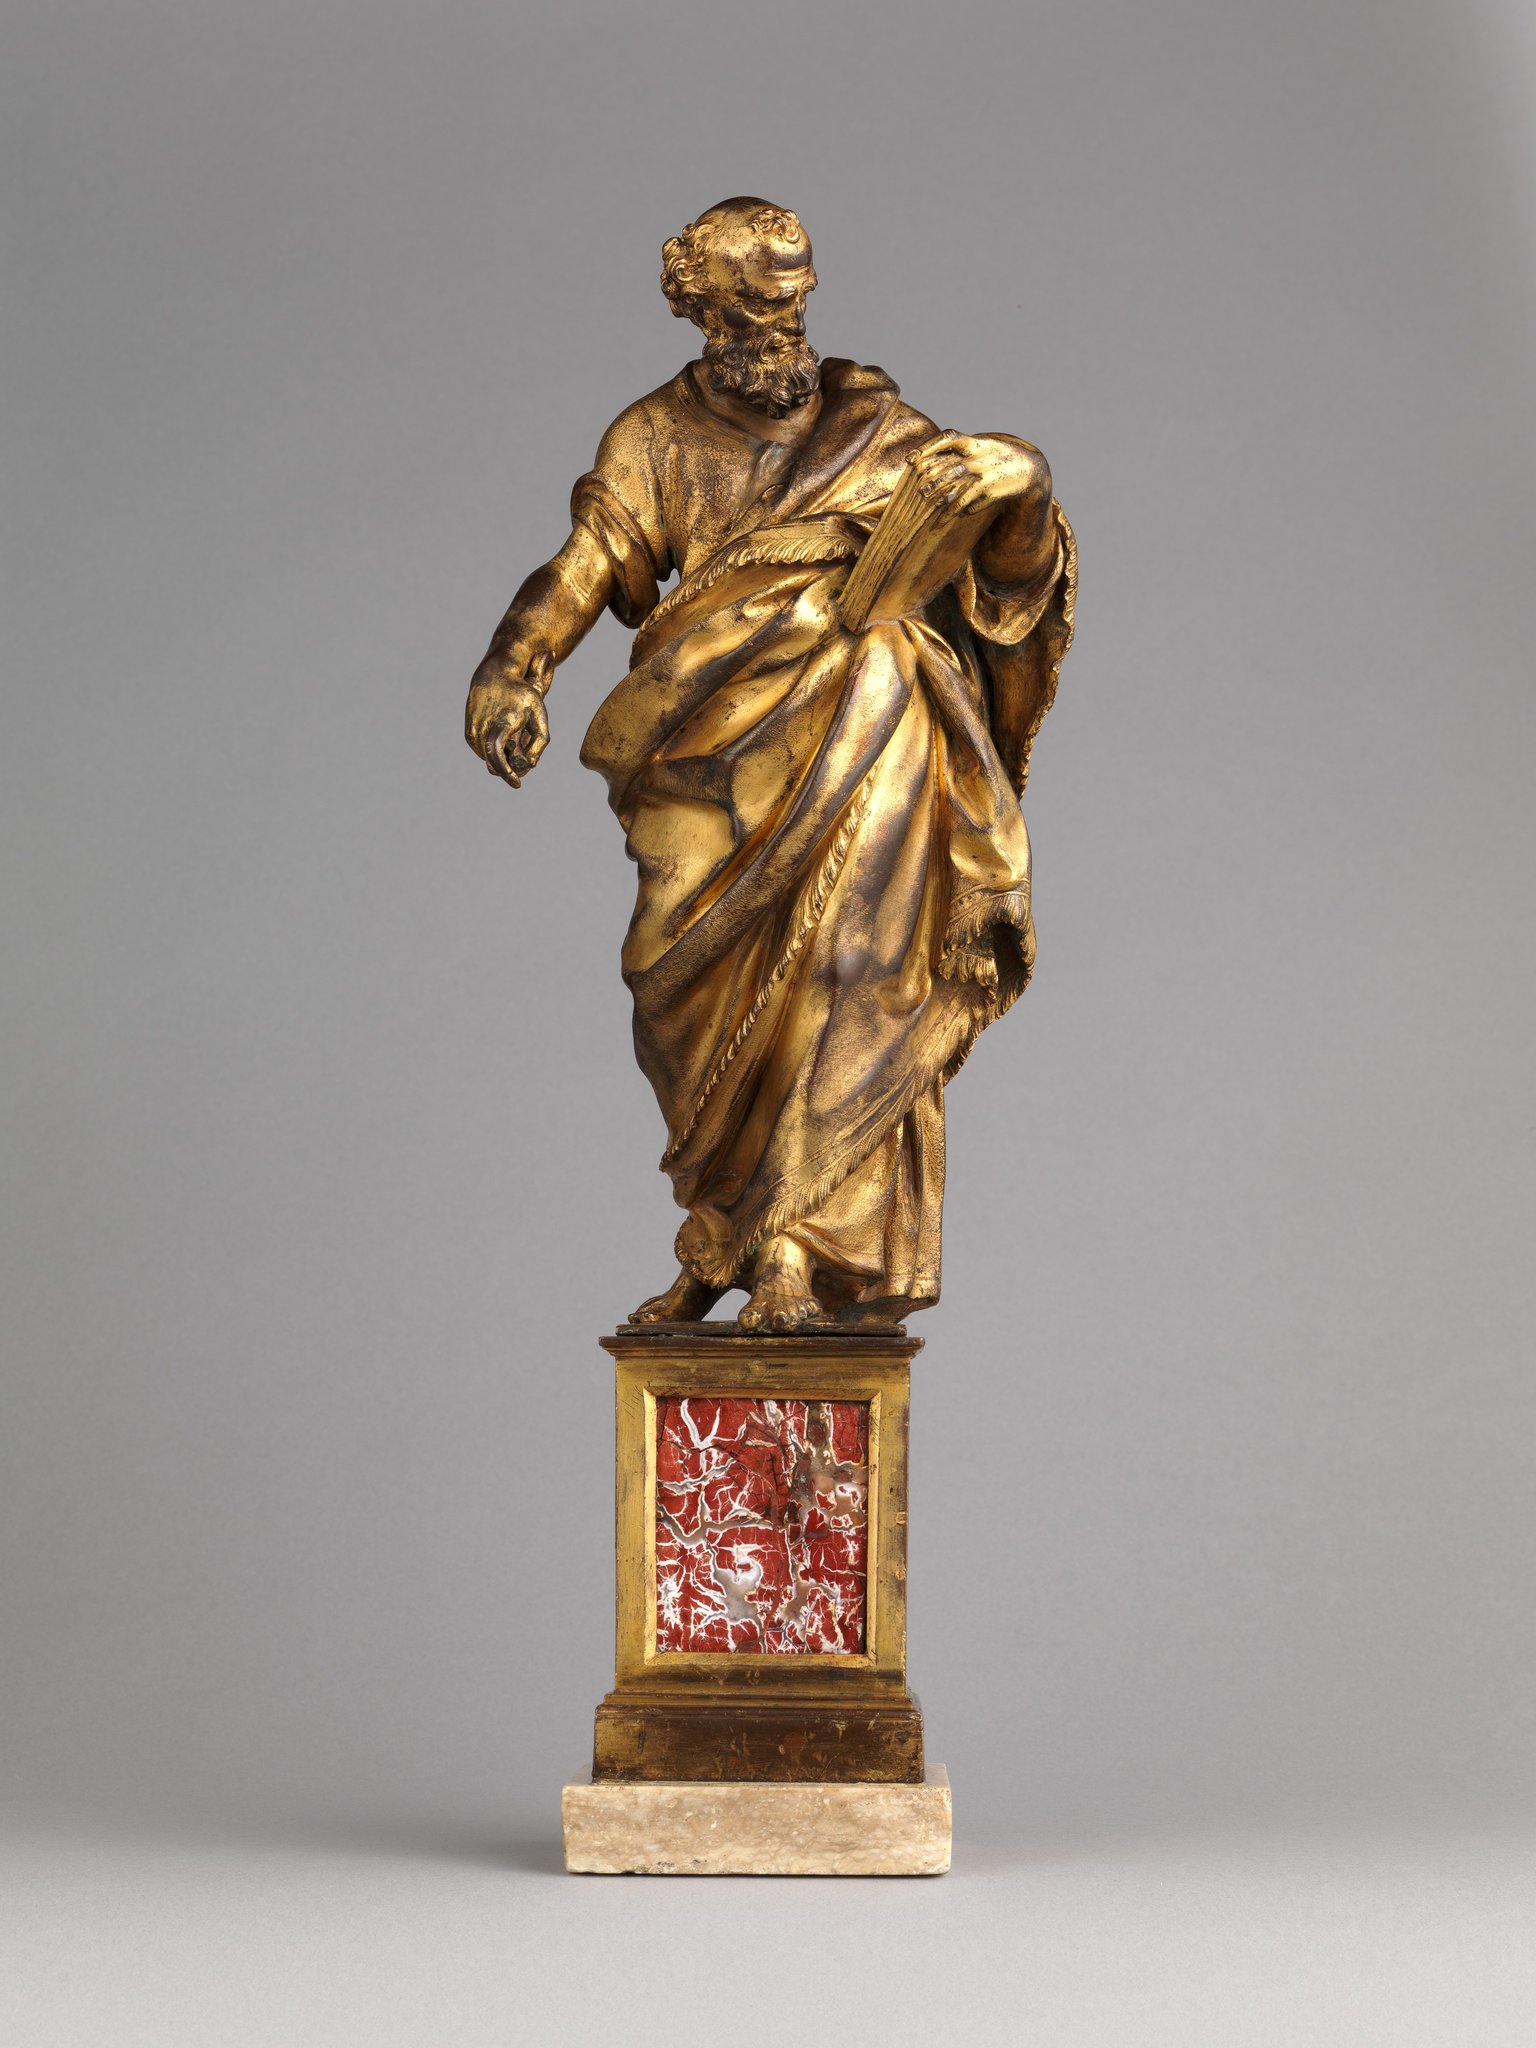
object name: statuette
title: Saint Peter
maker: cosimo fanzago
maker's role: artist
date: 1635-1636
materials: bronze, gilt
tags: books,saint peter